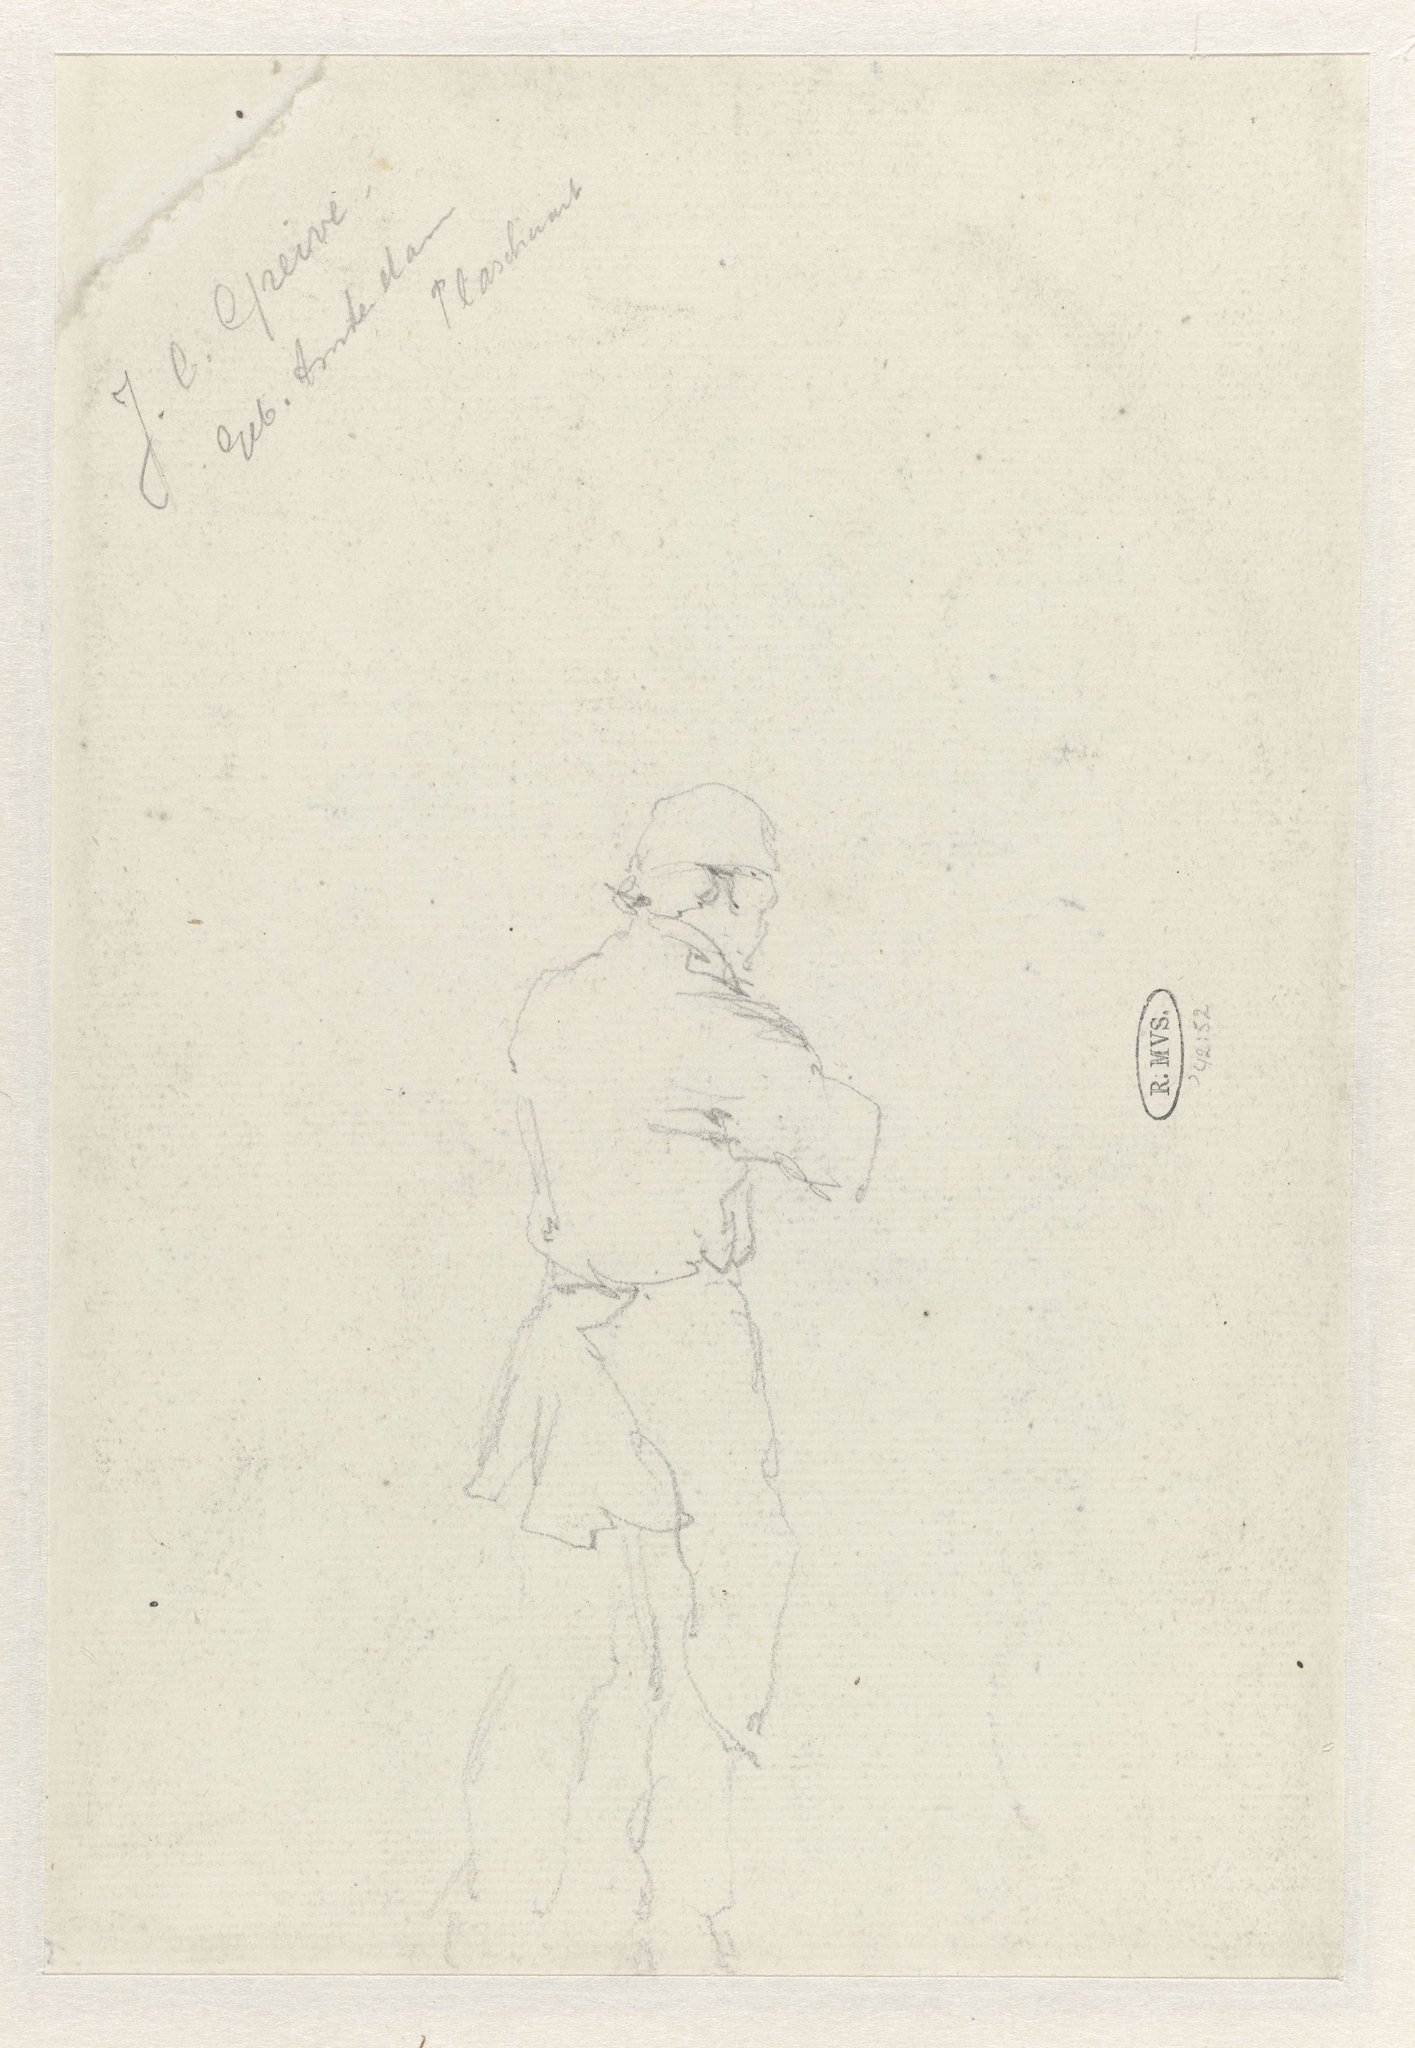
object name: drawing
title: Schets van een staande man, op de rug gezien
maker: johan conrad greive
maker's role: draughtsman, painter, print maker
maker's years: 1837-1891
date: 1847-1891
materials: paper, pencil